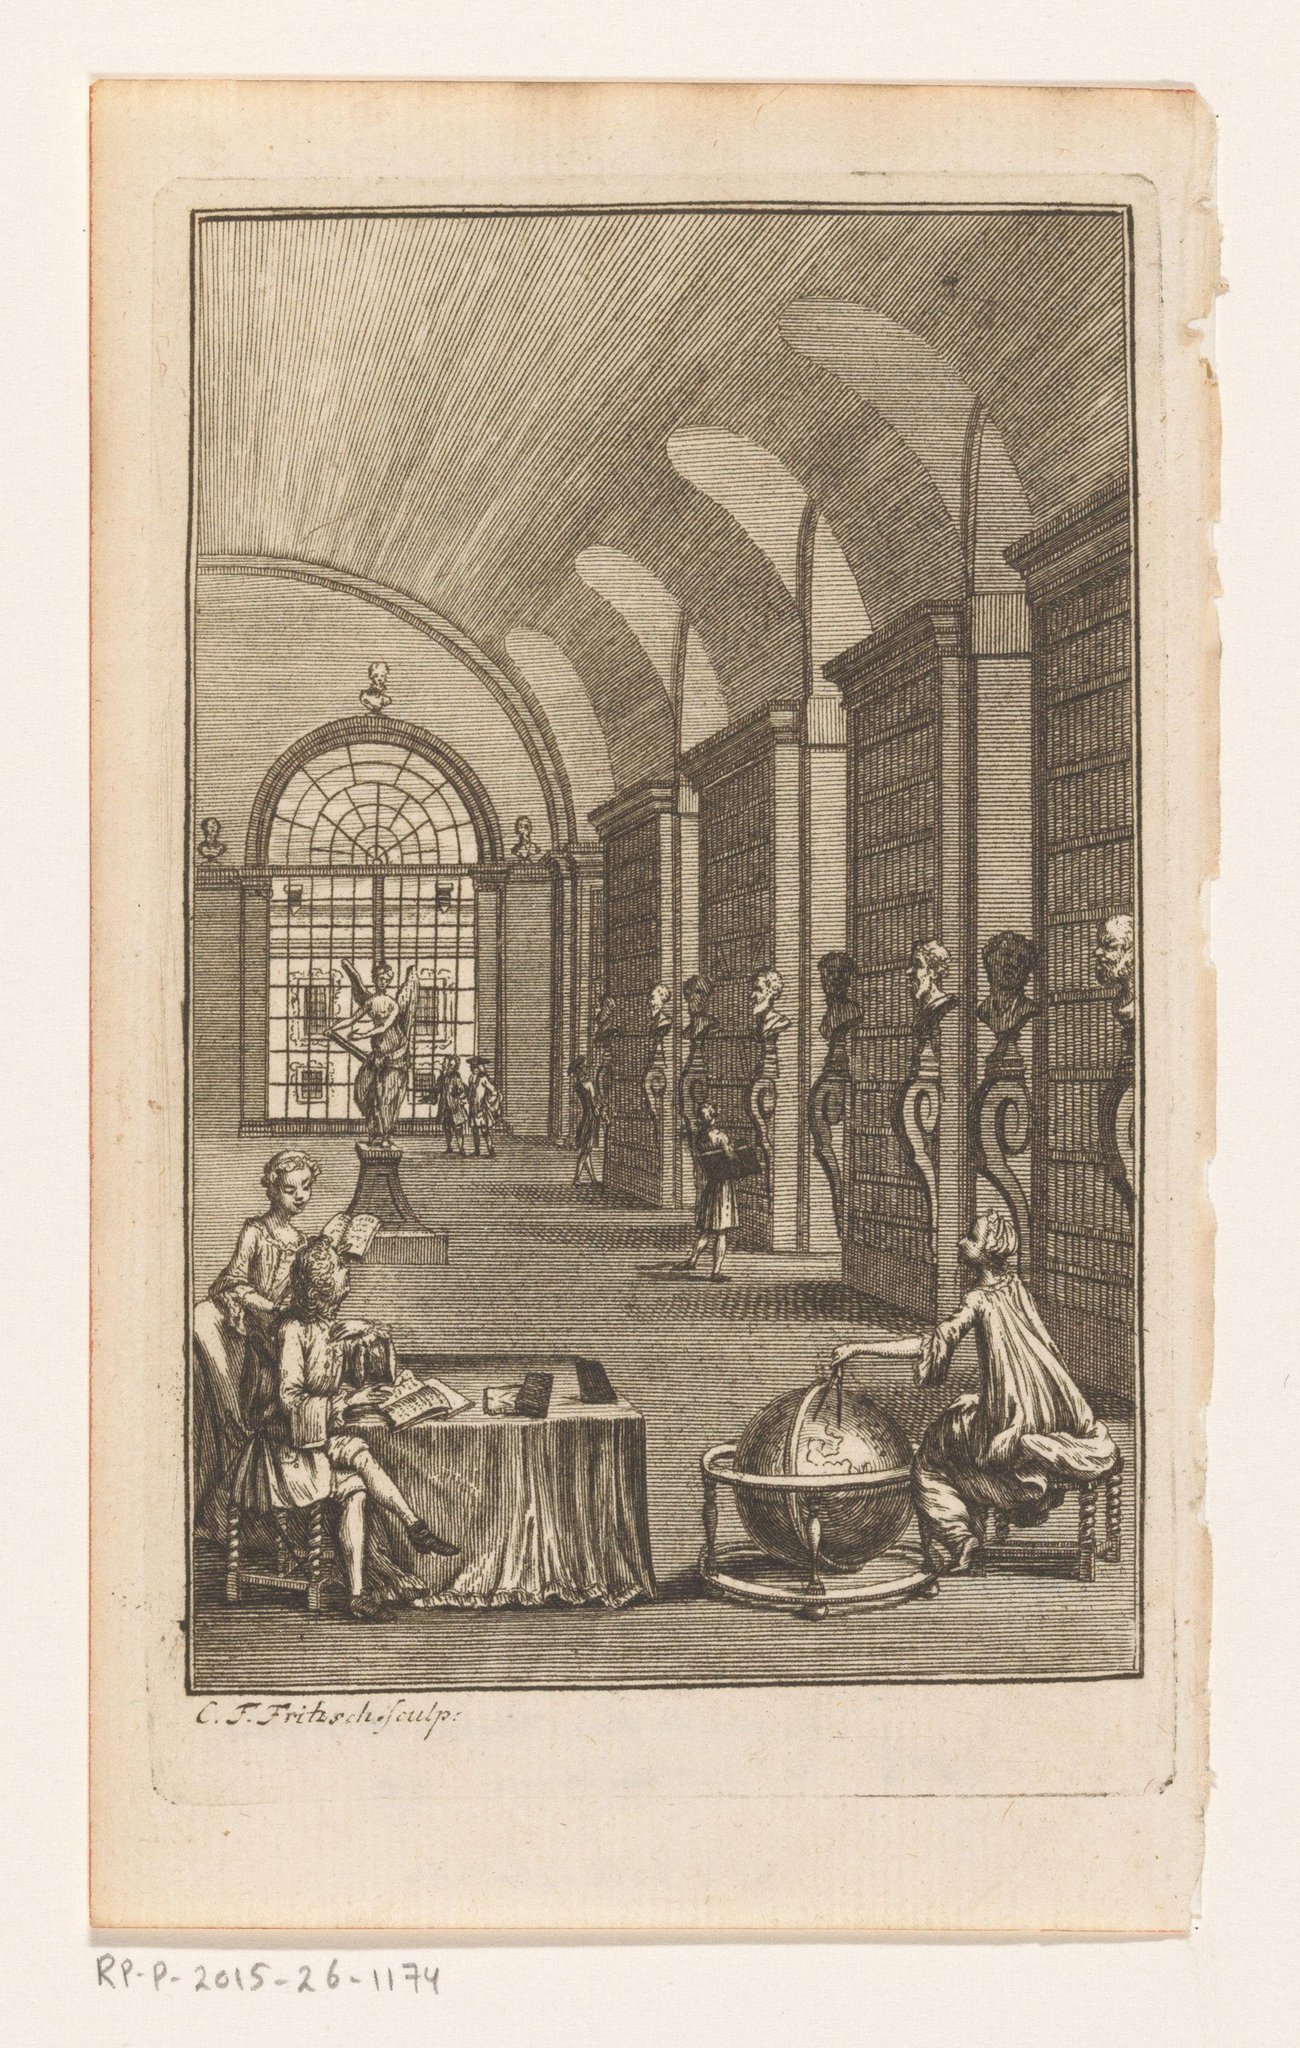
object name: titelblad, titelpagina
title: Titelpagina voor: Diogenes Laertius, Les vies des plus illustres philosophes de l'antiquité, 1758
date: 1758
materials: paper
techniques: etching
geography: amsterdam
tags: writing-table, writing-desk, globe, public library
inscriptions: collector's mark: Lugt 2228, collector's mark: Lugt 4779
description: Titelpagina voor: Diogenes Laertius, Les vies des plus illustres philosophes de l'antiquité. [Vertaald uit het Grieks door] Jacques George de Chaufepié. 3 dln. Amsterdam: Jean Herman Schneider, 1758, dl. 3.